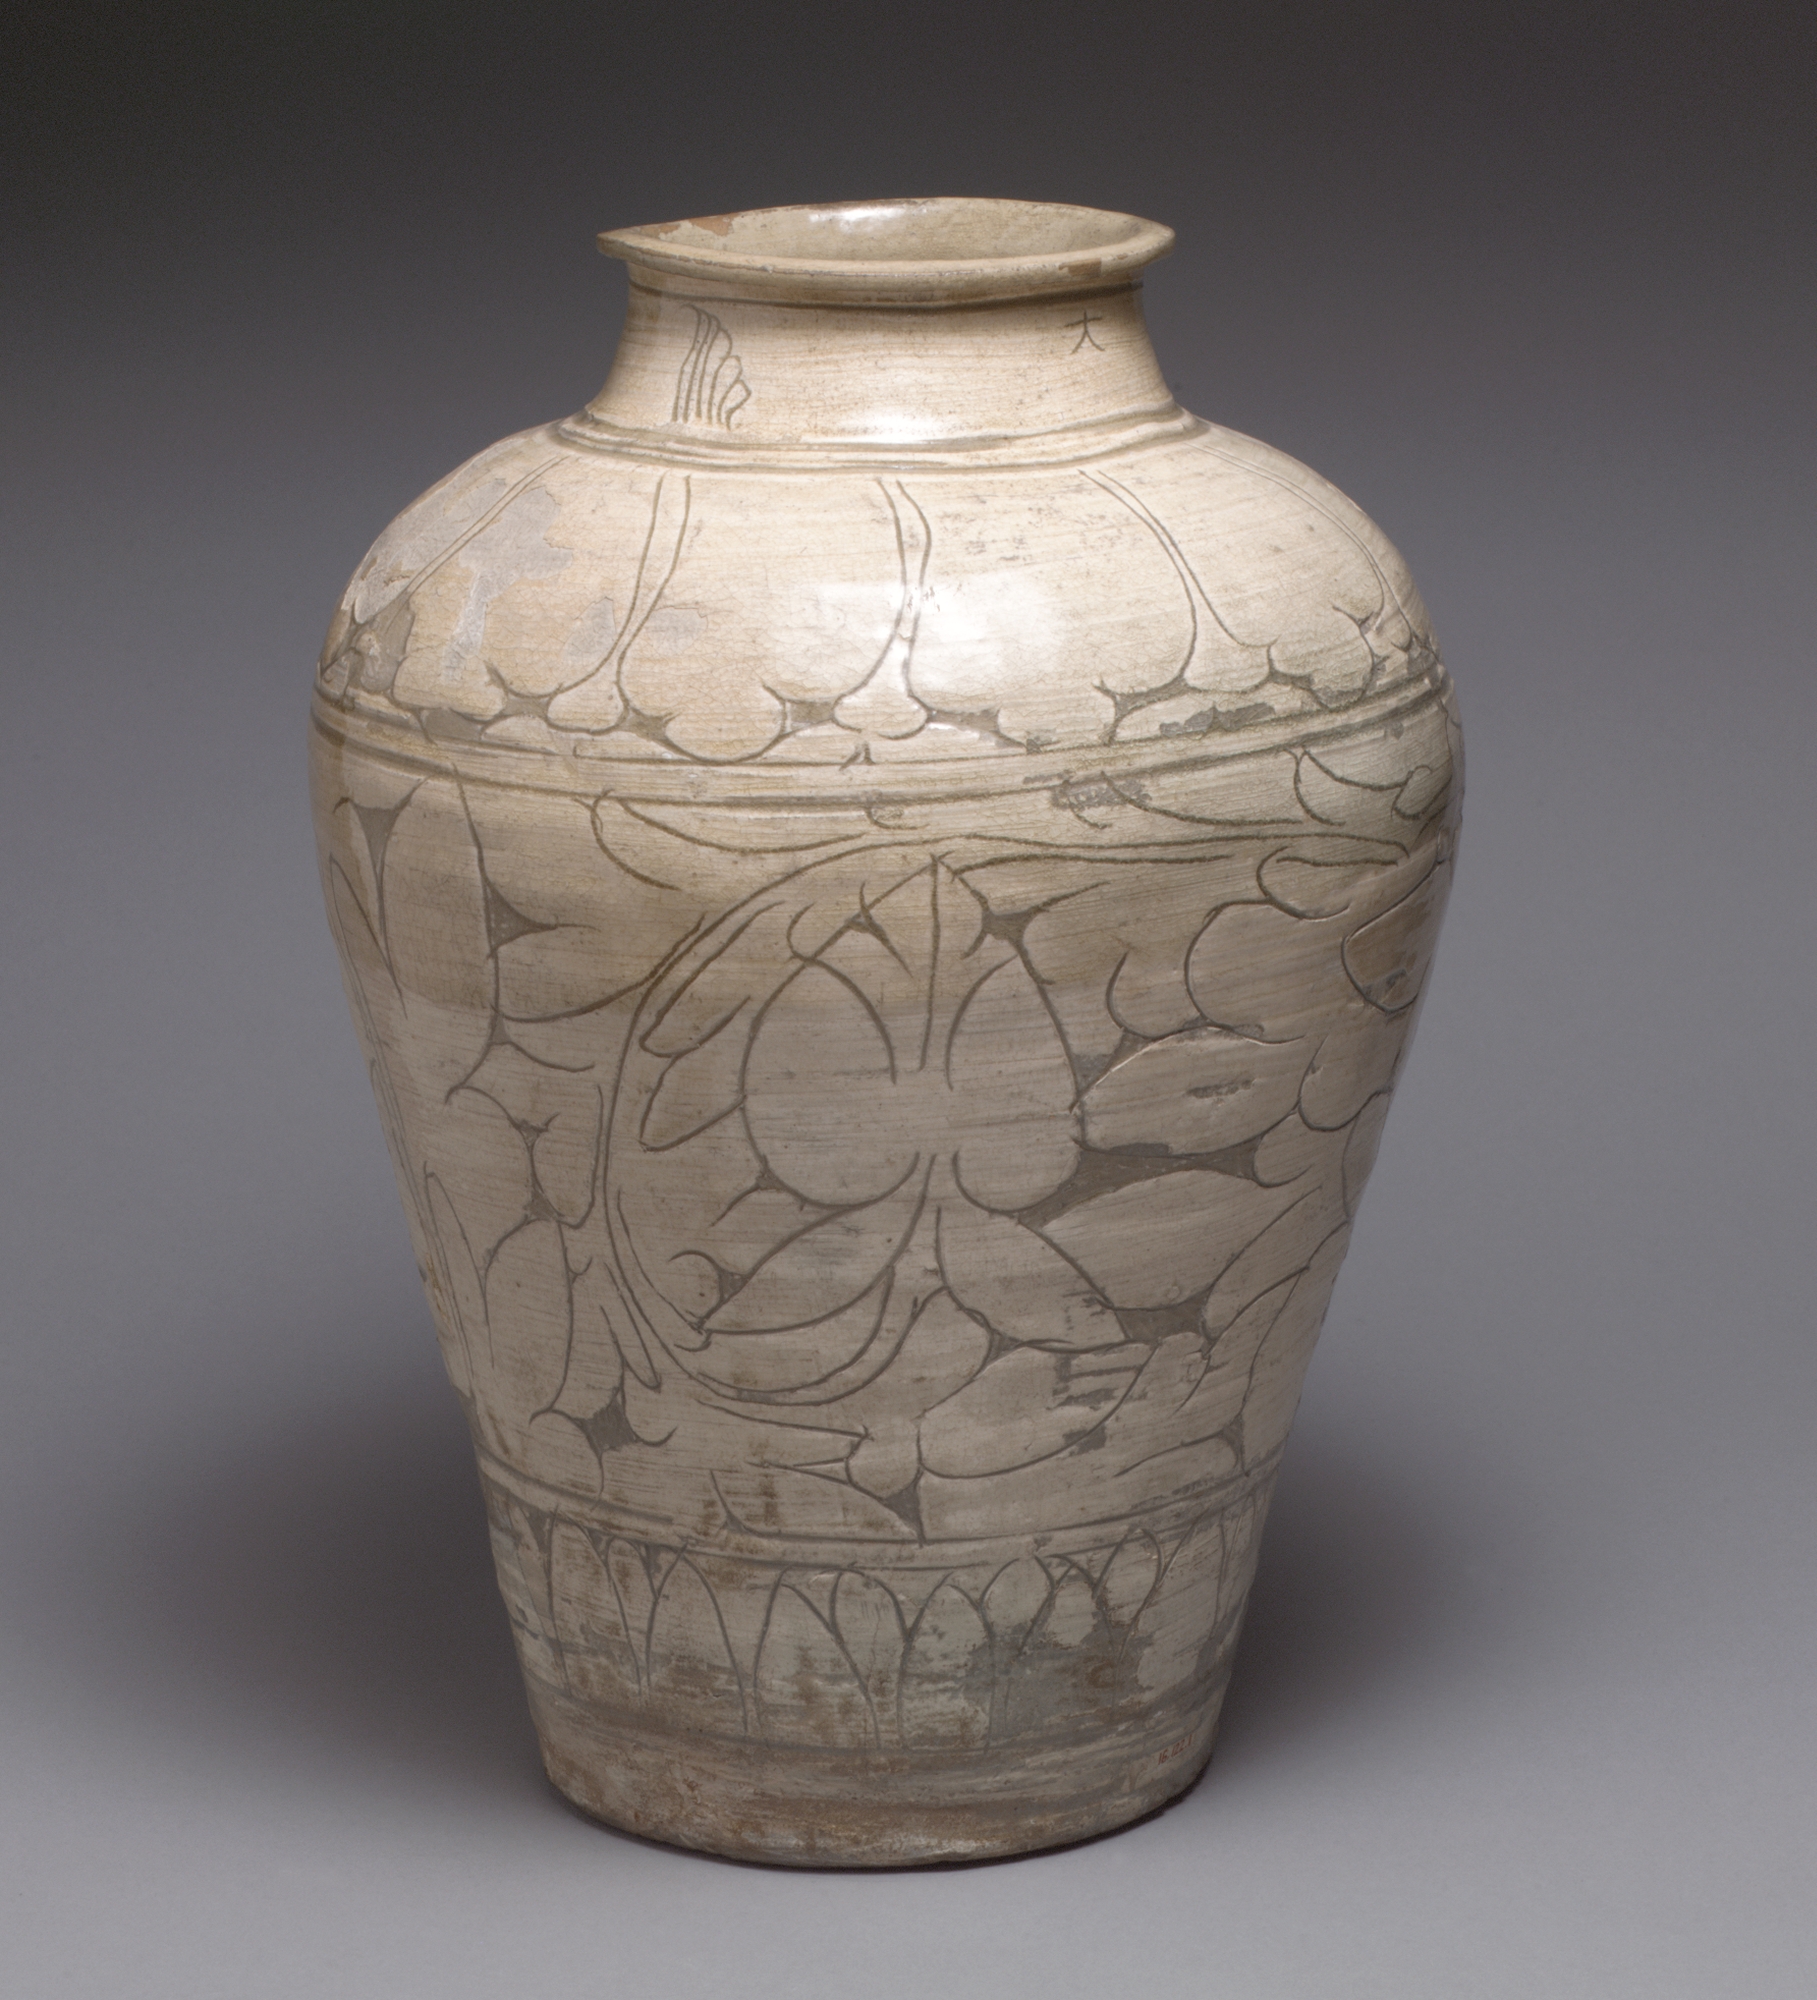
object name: jar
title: Large jar decorated with peonies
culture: korean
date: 1467-1500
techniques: incising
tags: peonies